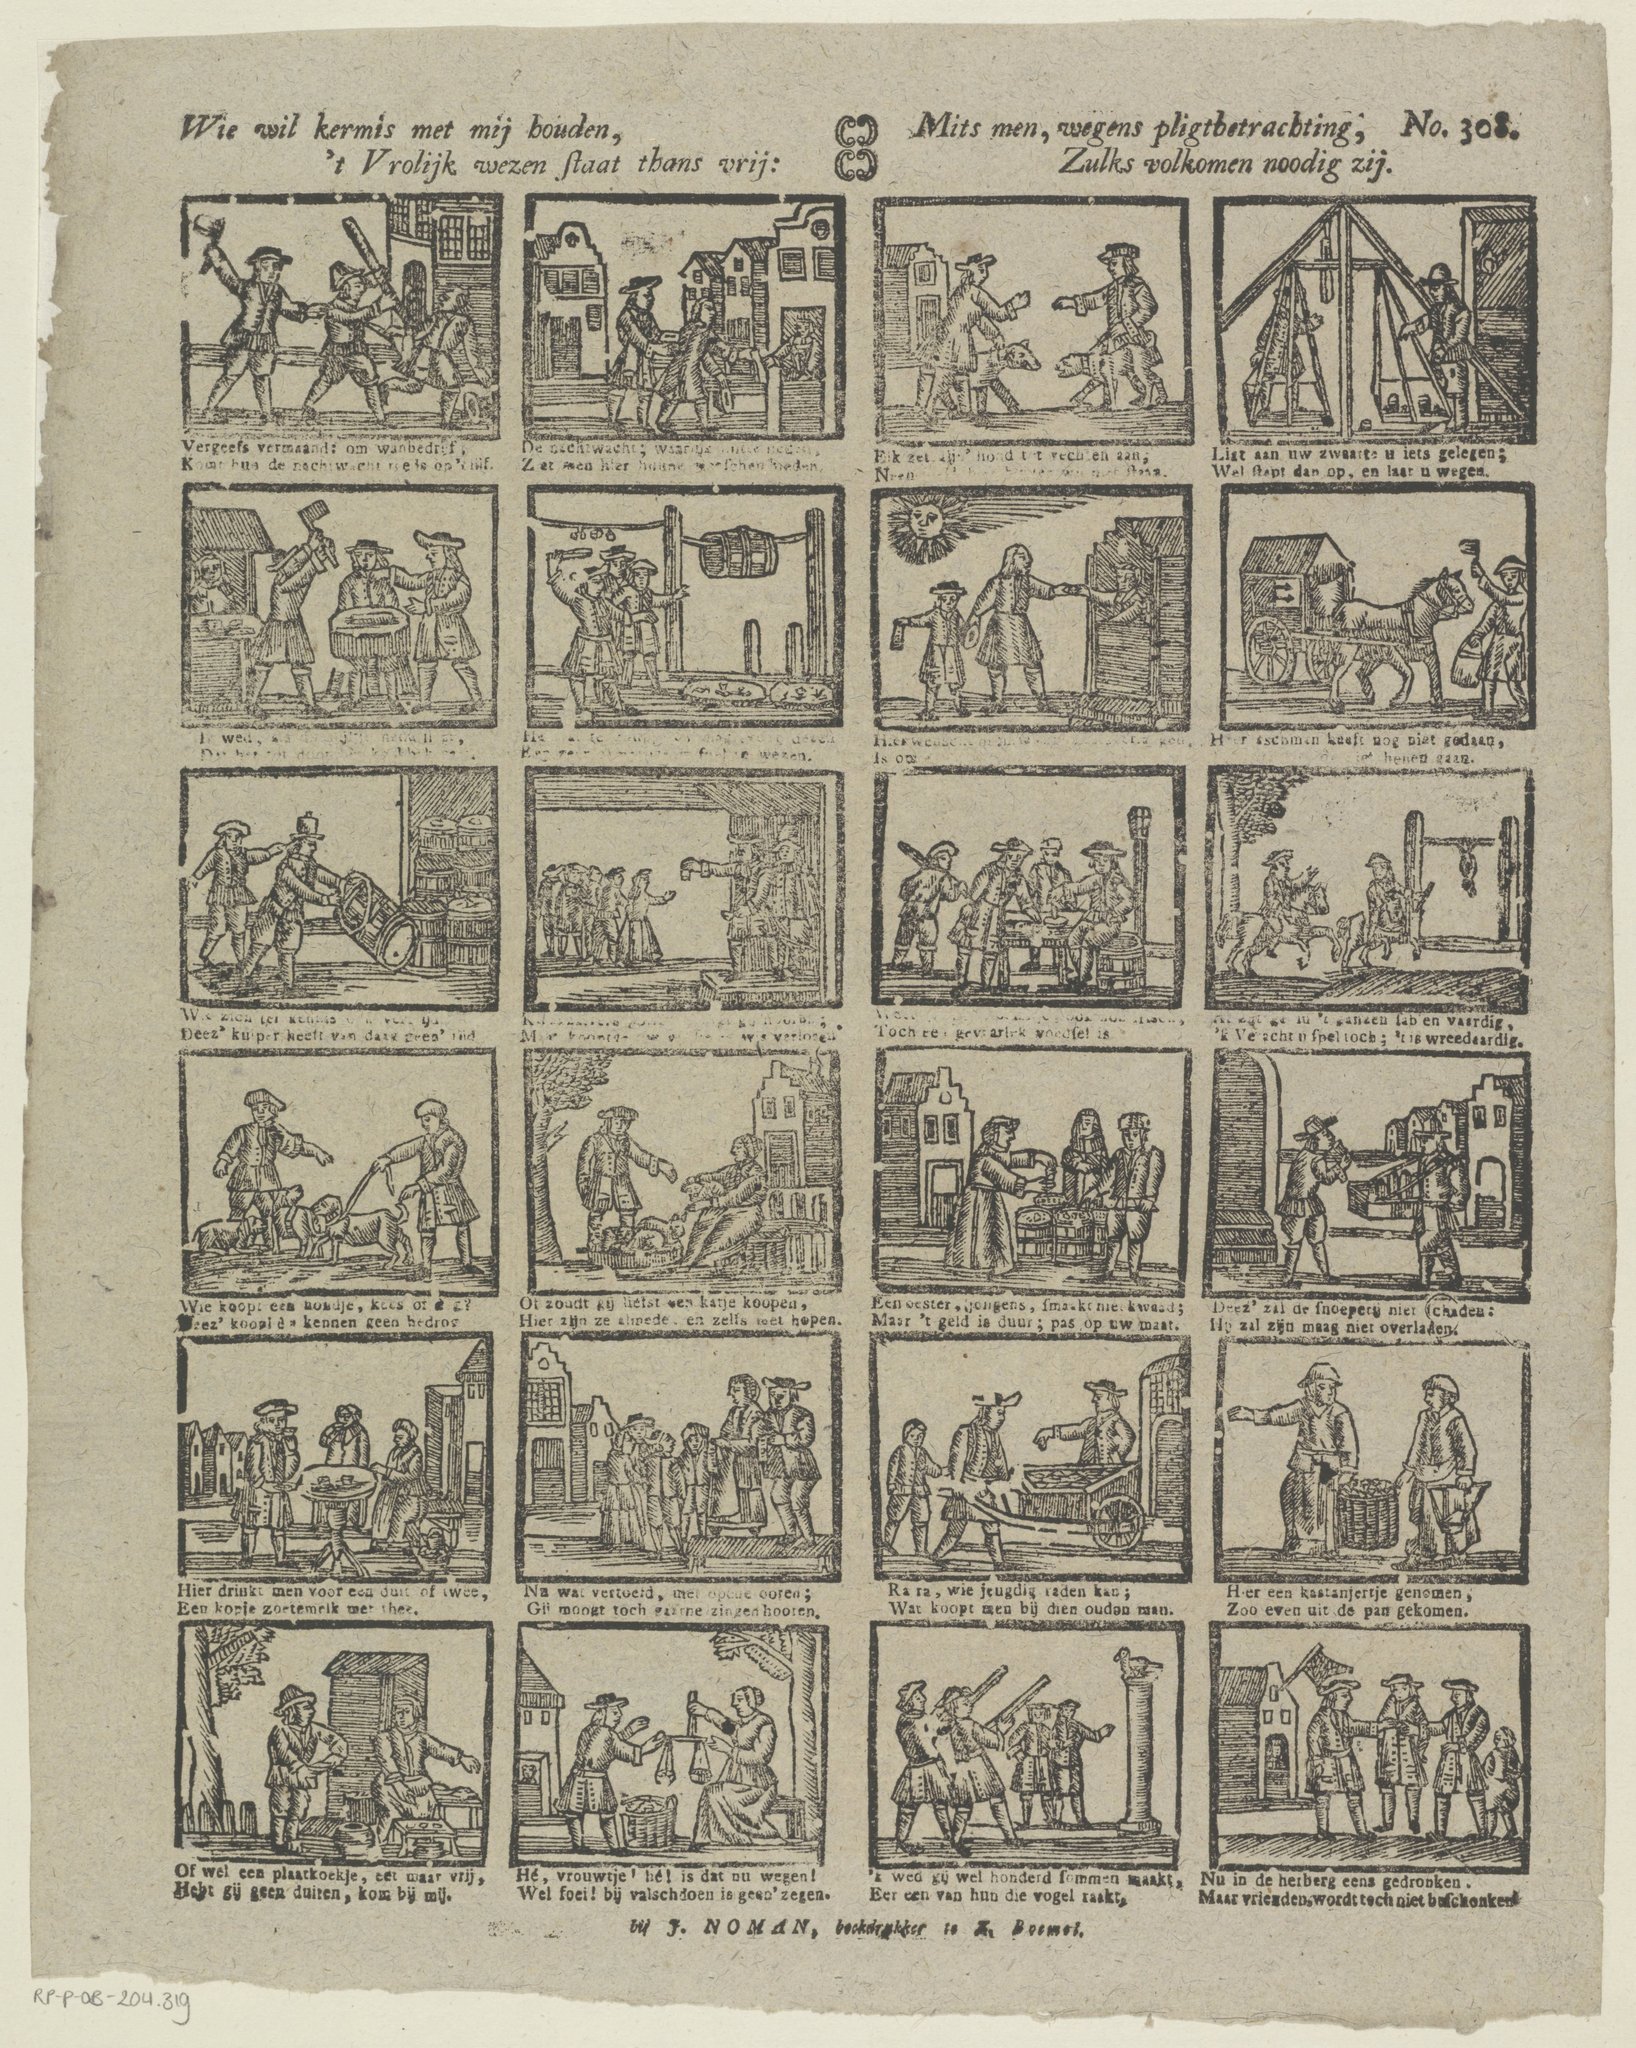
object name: popular print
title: Wie wil kermis met mij houden, / 't vrolijk wezen staat thans vrij: / Mits men, wegens pligtbetrachting, / Zulks volkomen noodig zij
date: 1806-1830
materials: paper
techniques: letterpress printing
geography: zaltbommel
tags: pleasure fair and circus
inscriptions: collector's mark: Lugt 2760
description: Blad met 24 kermistaferelen. Onder elke afbeelding een tweeregelig vers. Genummerd rechtsboven: No. 308.